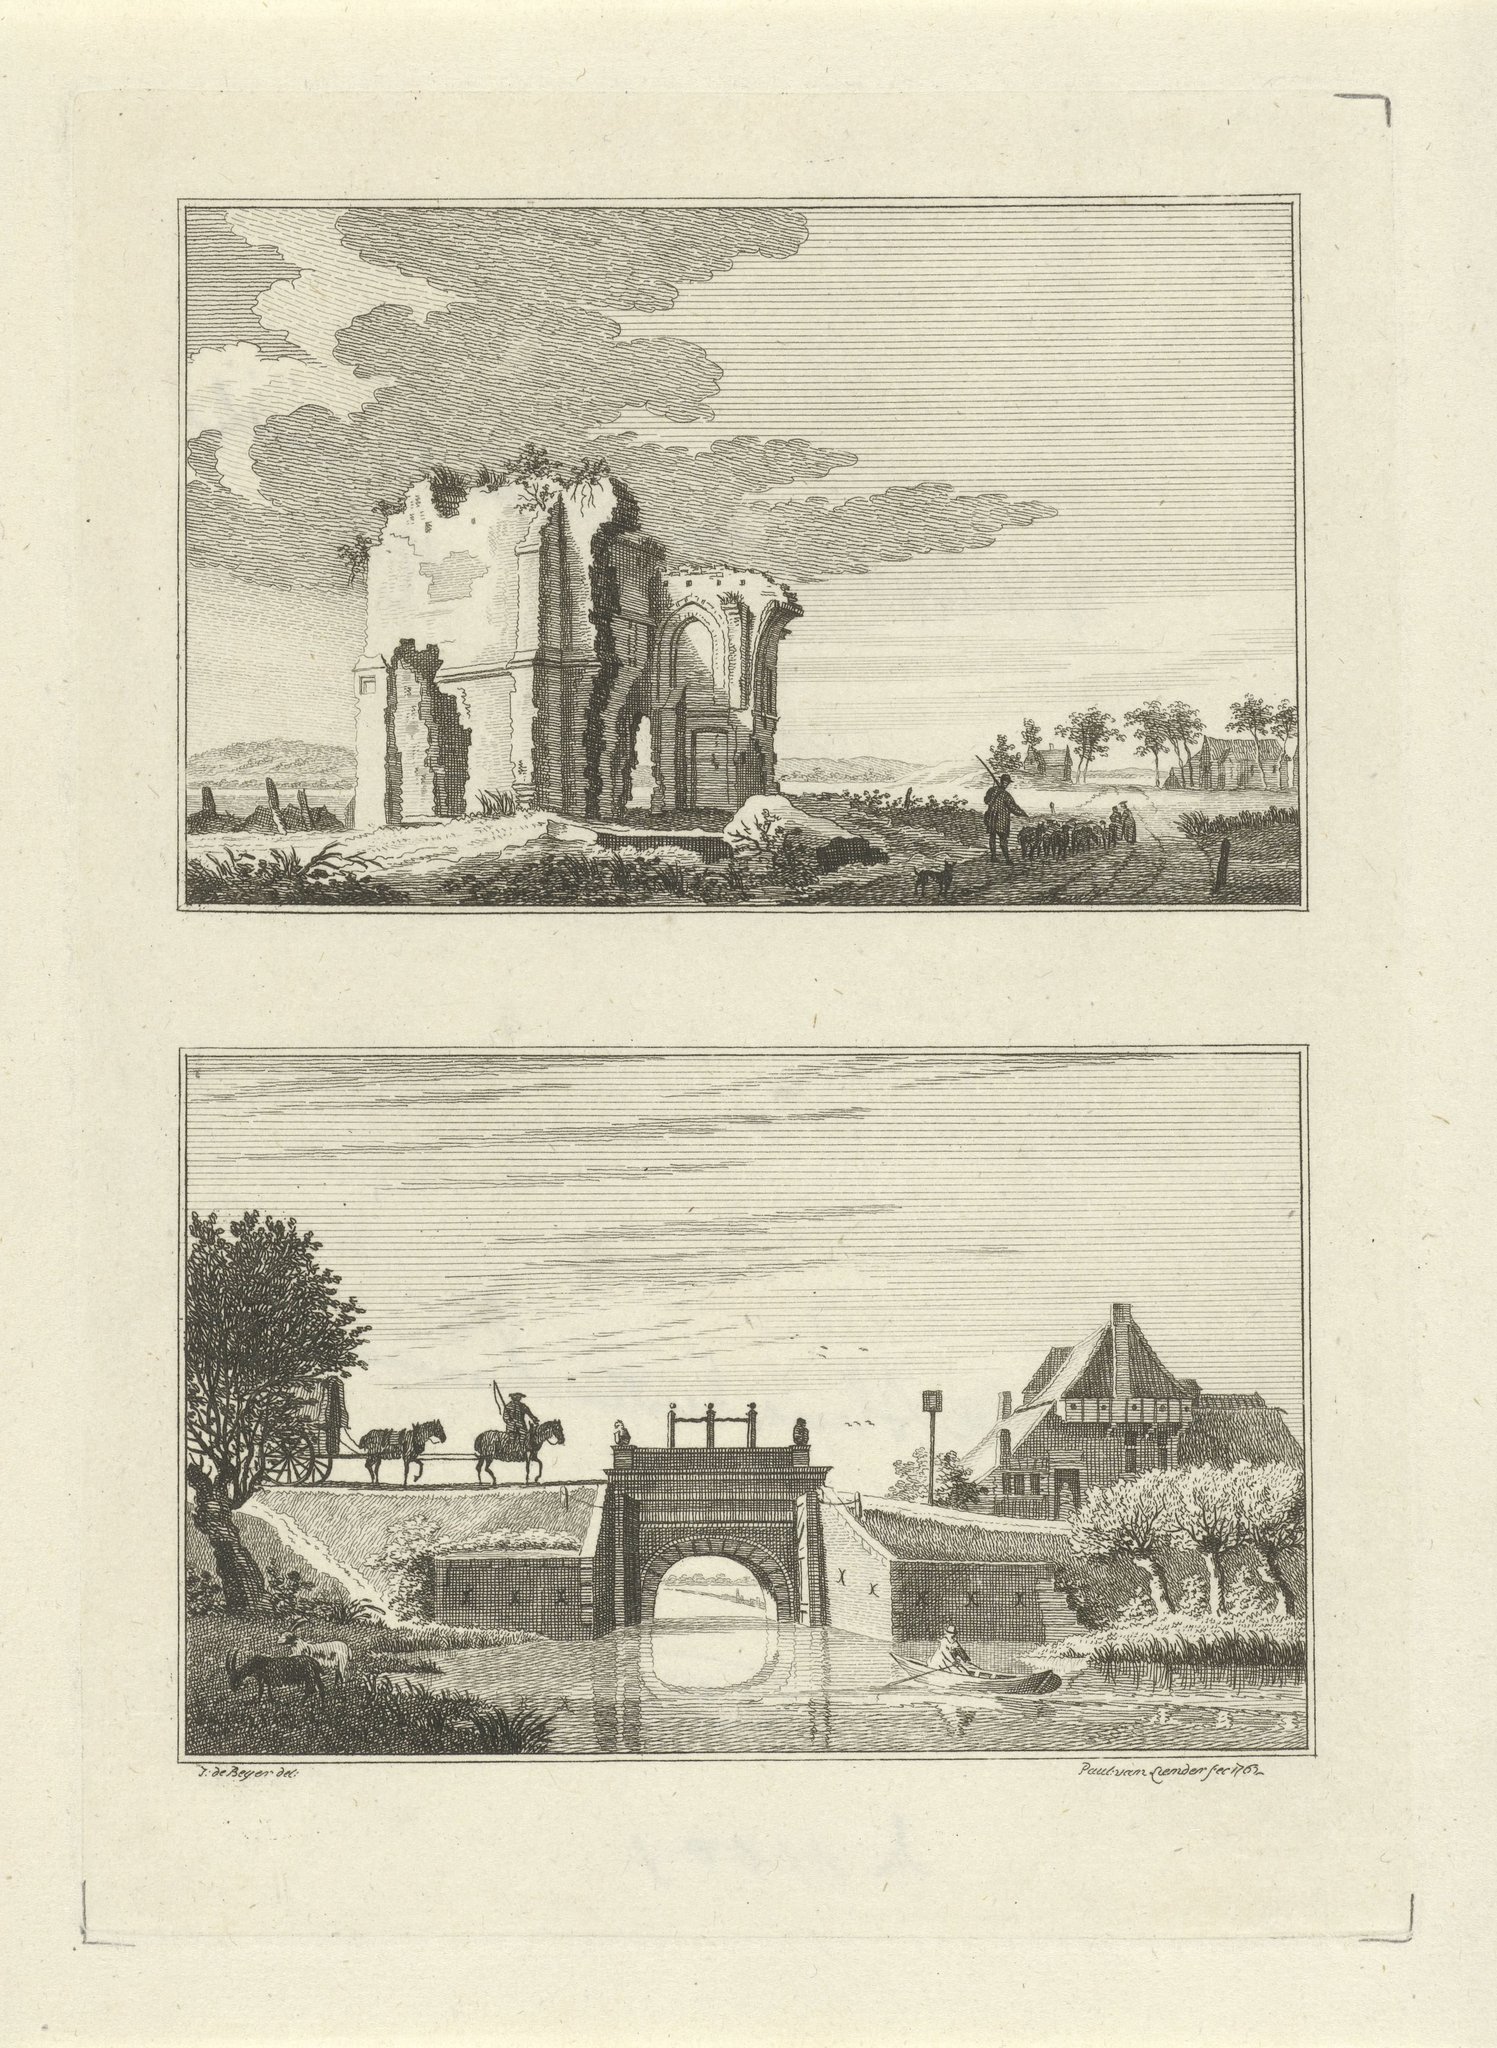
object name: print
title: Ruïne en sluis buiten Emmerik, 1732-1736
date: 1762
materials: paper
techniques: etching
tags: sluice, weir, ruin of church, monastery, etc.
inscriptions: collector's mark: Lugt 2228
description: Twee voorstellingen van één plaat. Gezicht op de ruïne van een klooster (boven) en een sluis (onder) buiten de Duitse stad Emmerik. De prent maakt deel uit van een 100-delige serie met gezichten op dorpen en steden te Kleef.